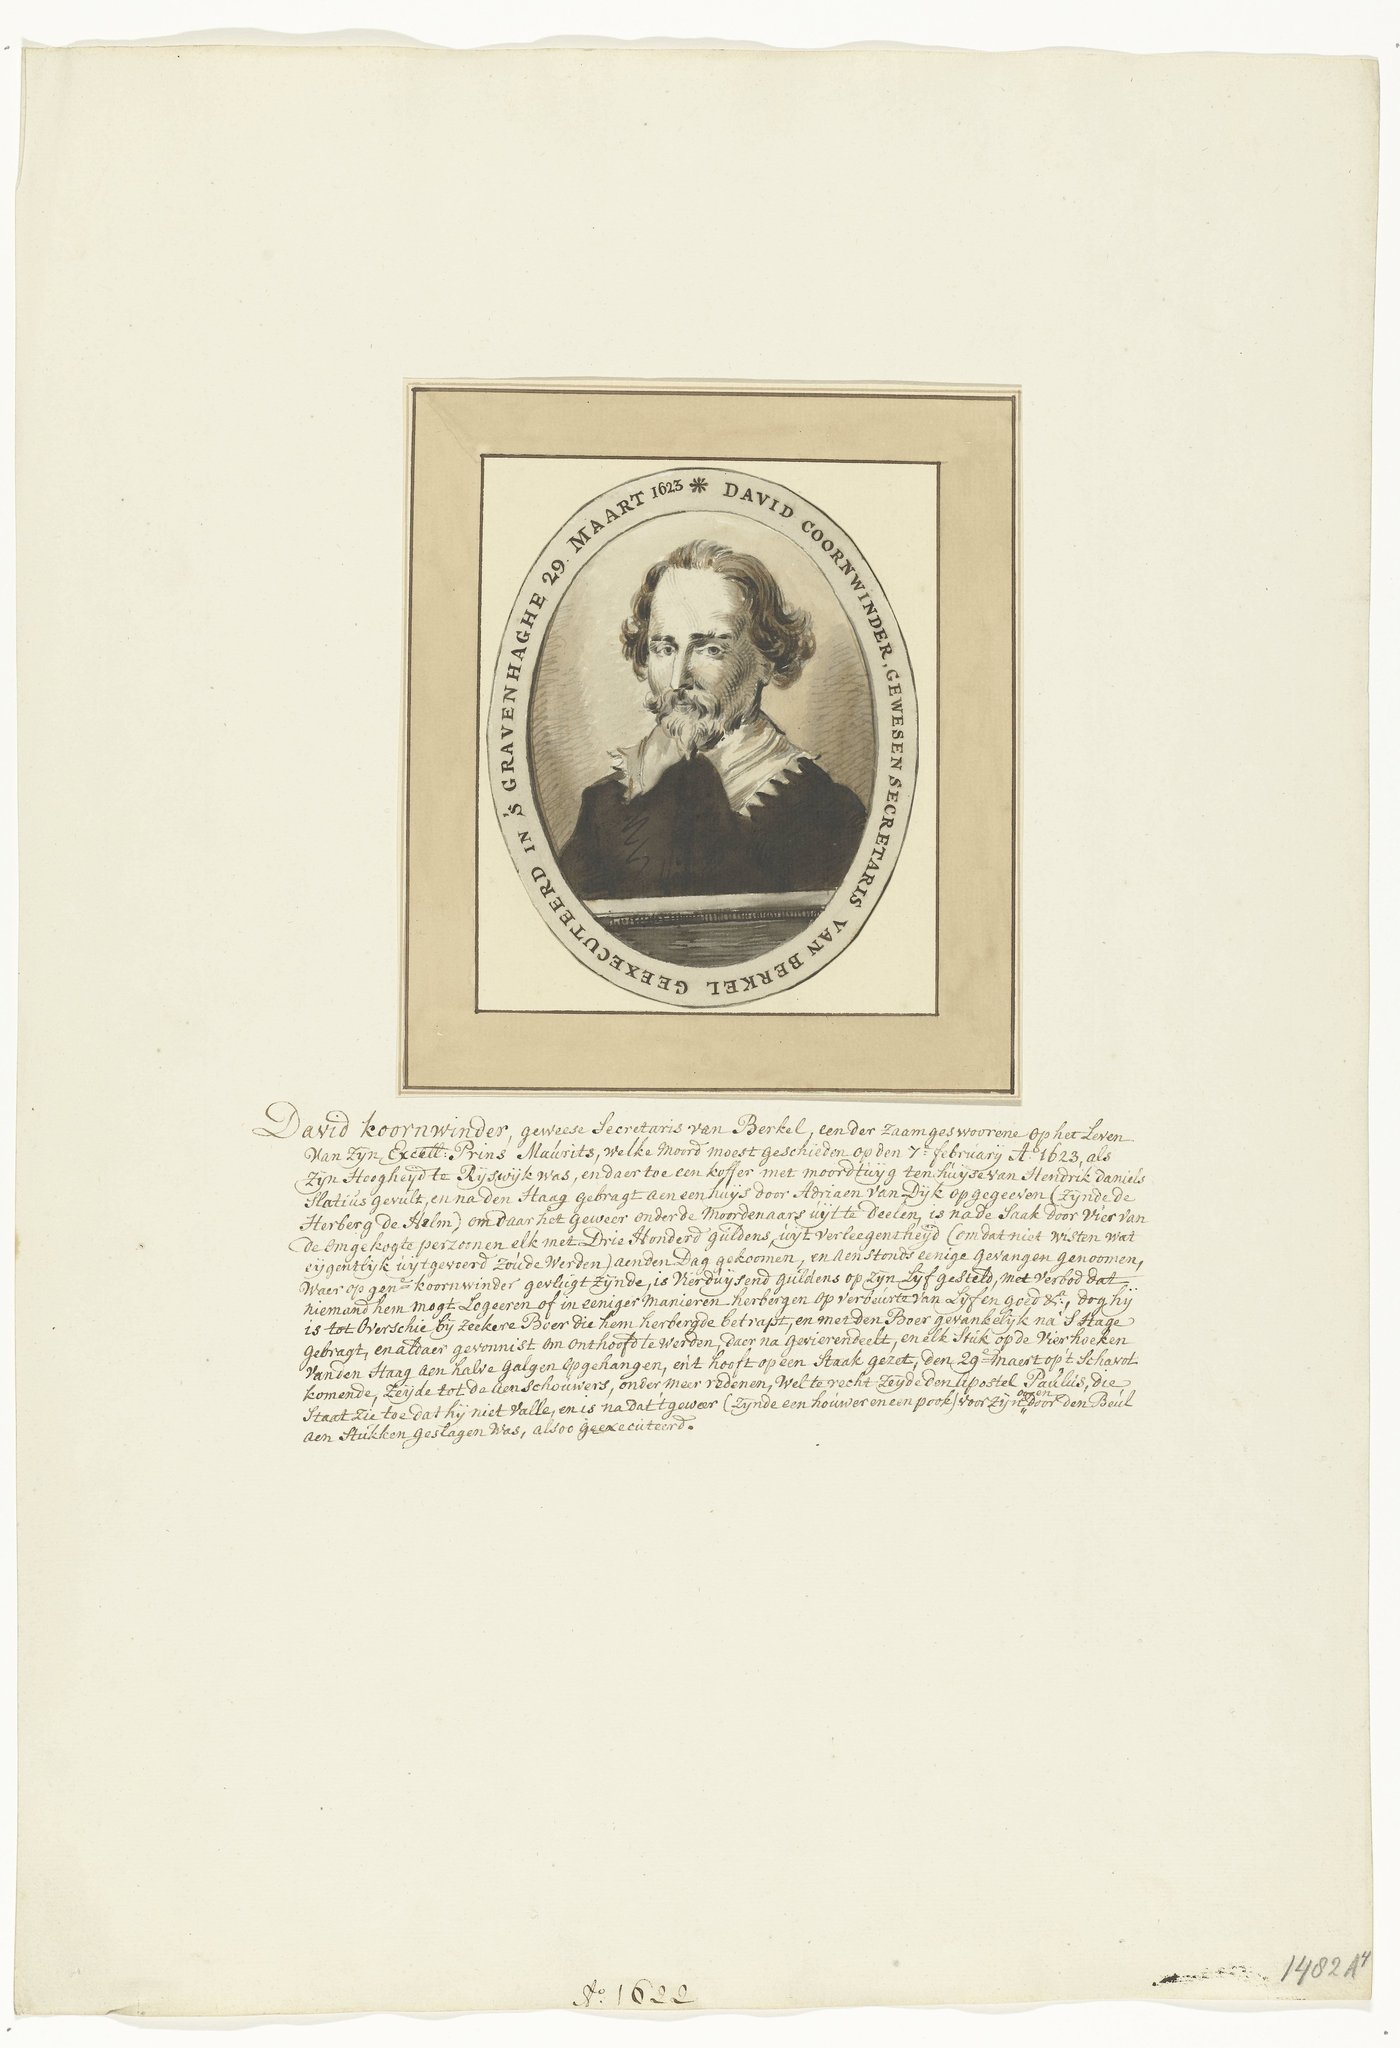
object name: drawing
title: Negen getekende portretten van de samenzweerders tegen Mauritis in 1623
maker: tako hajo jelgersma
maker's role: draughtsman, painter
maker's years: 1702-1795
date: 1715-1795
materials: paper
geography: netherlands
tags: (revolutionary) plot, conspiracy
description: Portret van David Coorenwinder, één van de samenzweerders tegen Maurits in 1623. Borstbeeld in ovaal, naar links. Met randschrift in het Nederlands. Op het blad onder het opgeplakte portret een handgeschreven levensbeschrijving van de afgebeelde persoon.